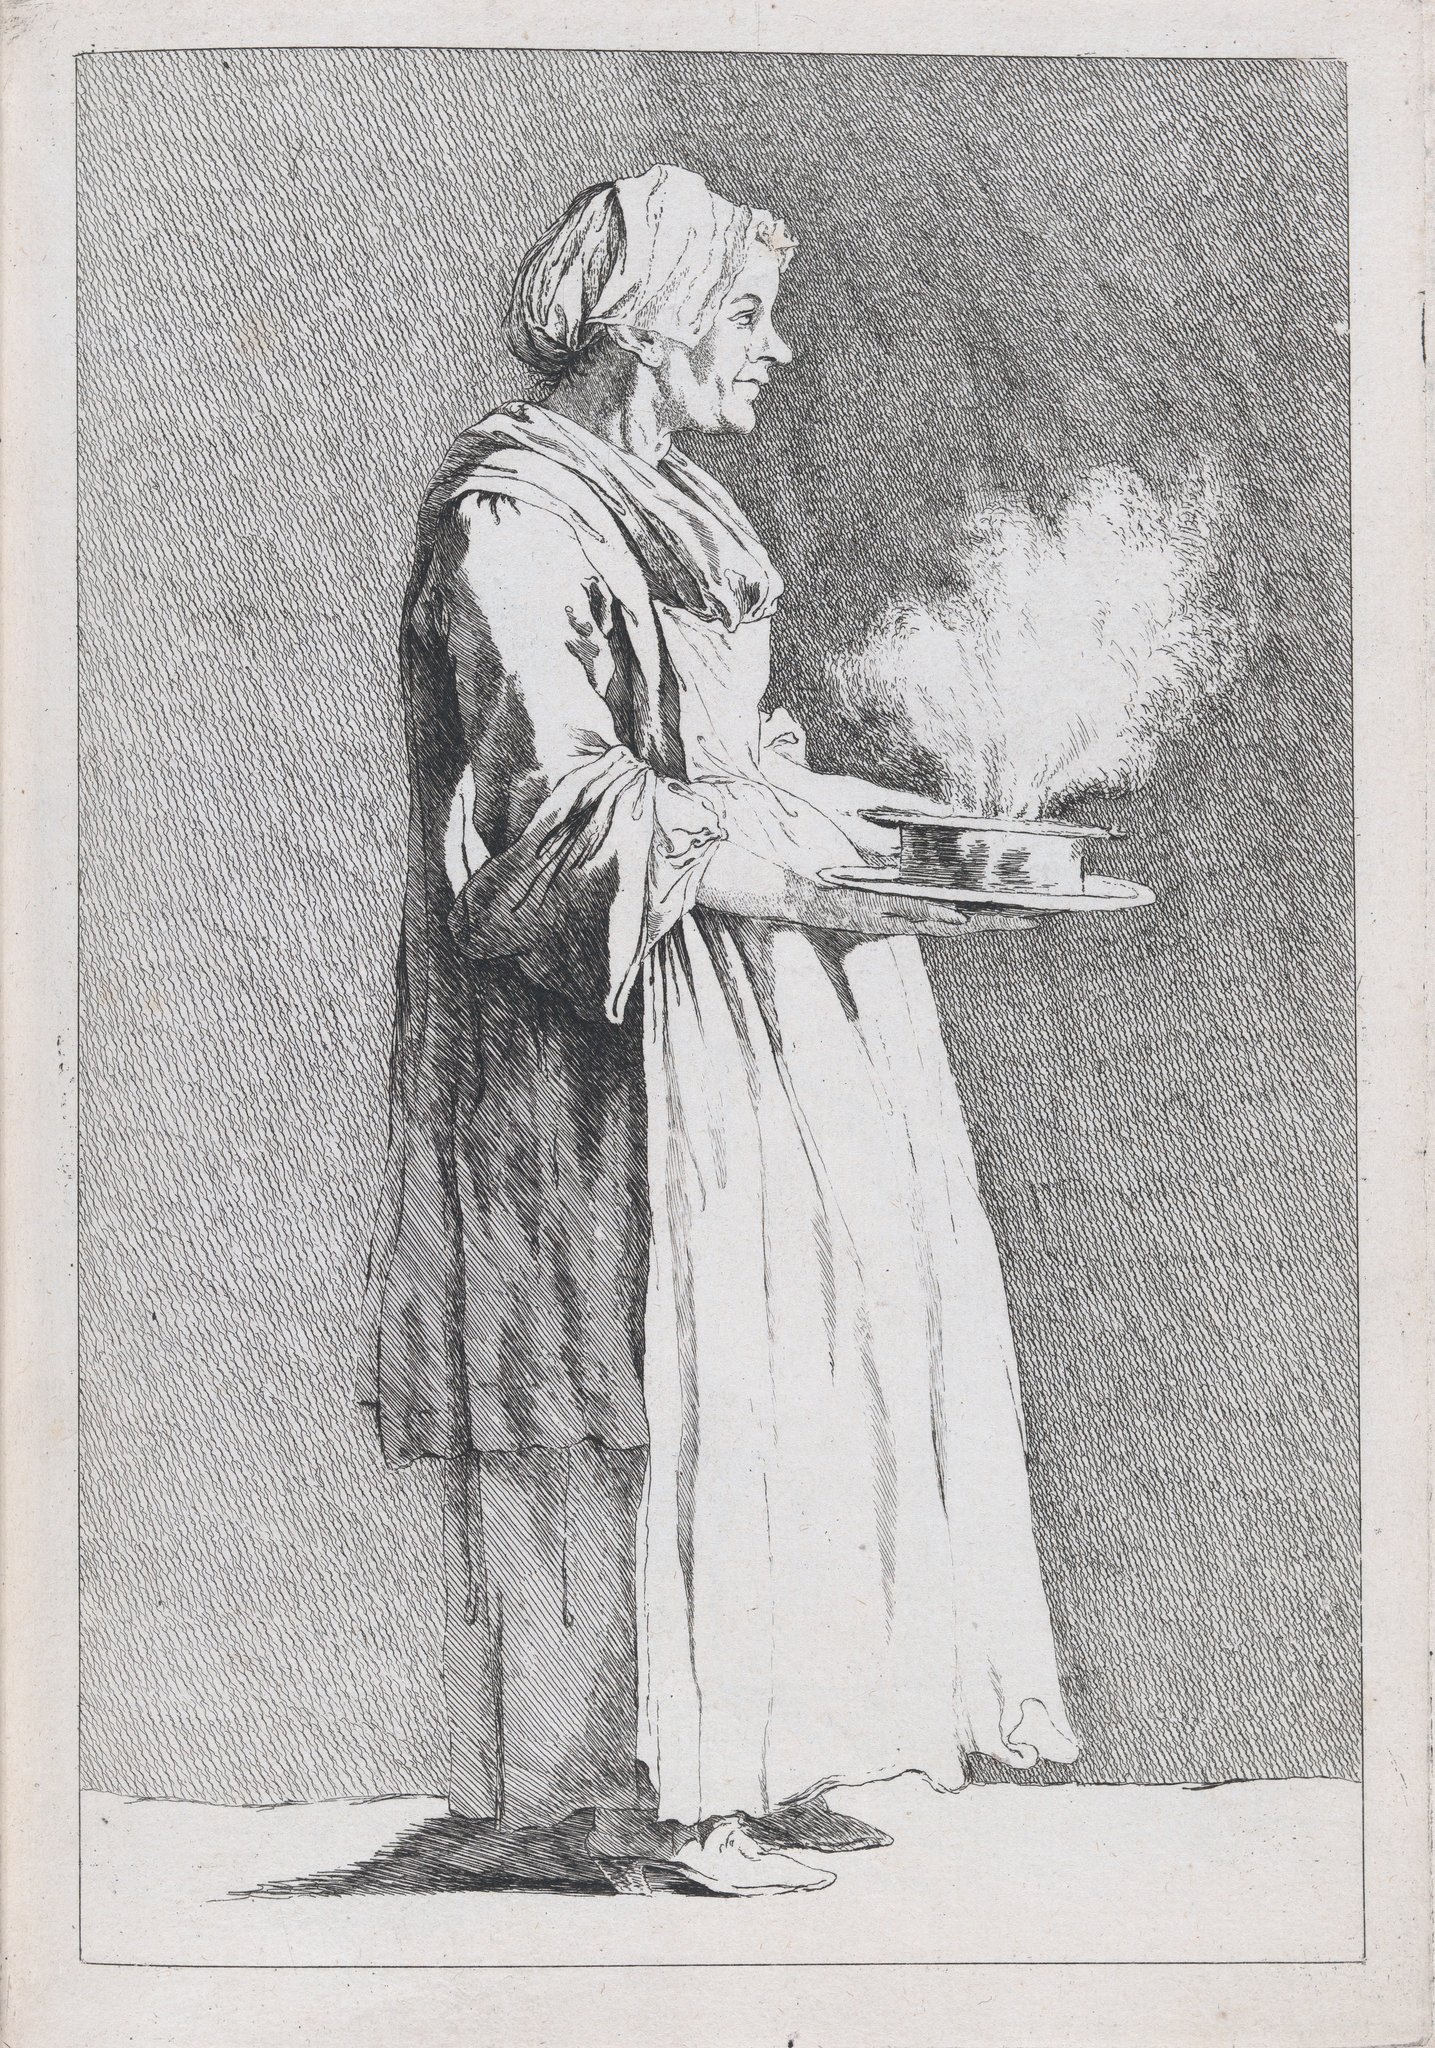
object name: print, album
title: Rosa Diupert, Wife of Nicolas Bremont, Cook at the French Academy in Rome, pl. X from "Recueil de caricatures"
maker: ange-laurent de la live de jully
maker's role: artist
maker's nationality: french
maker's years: 1725-1779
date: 1754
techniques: etching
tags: profiles,women